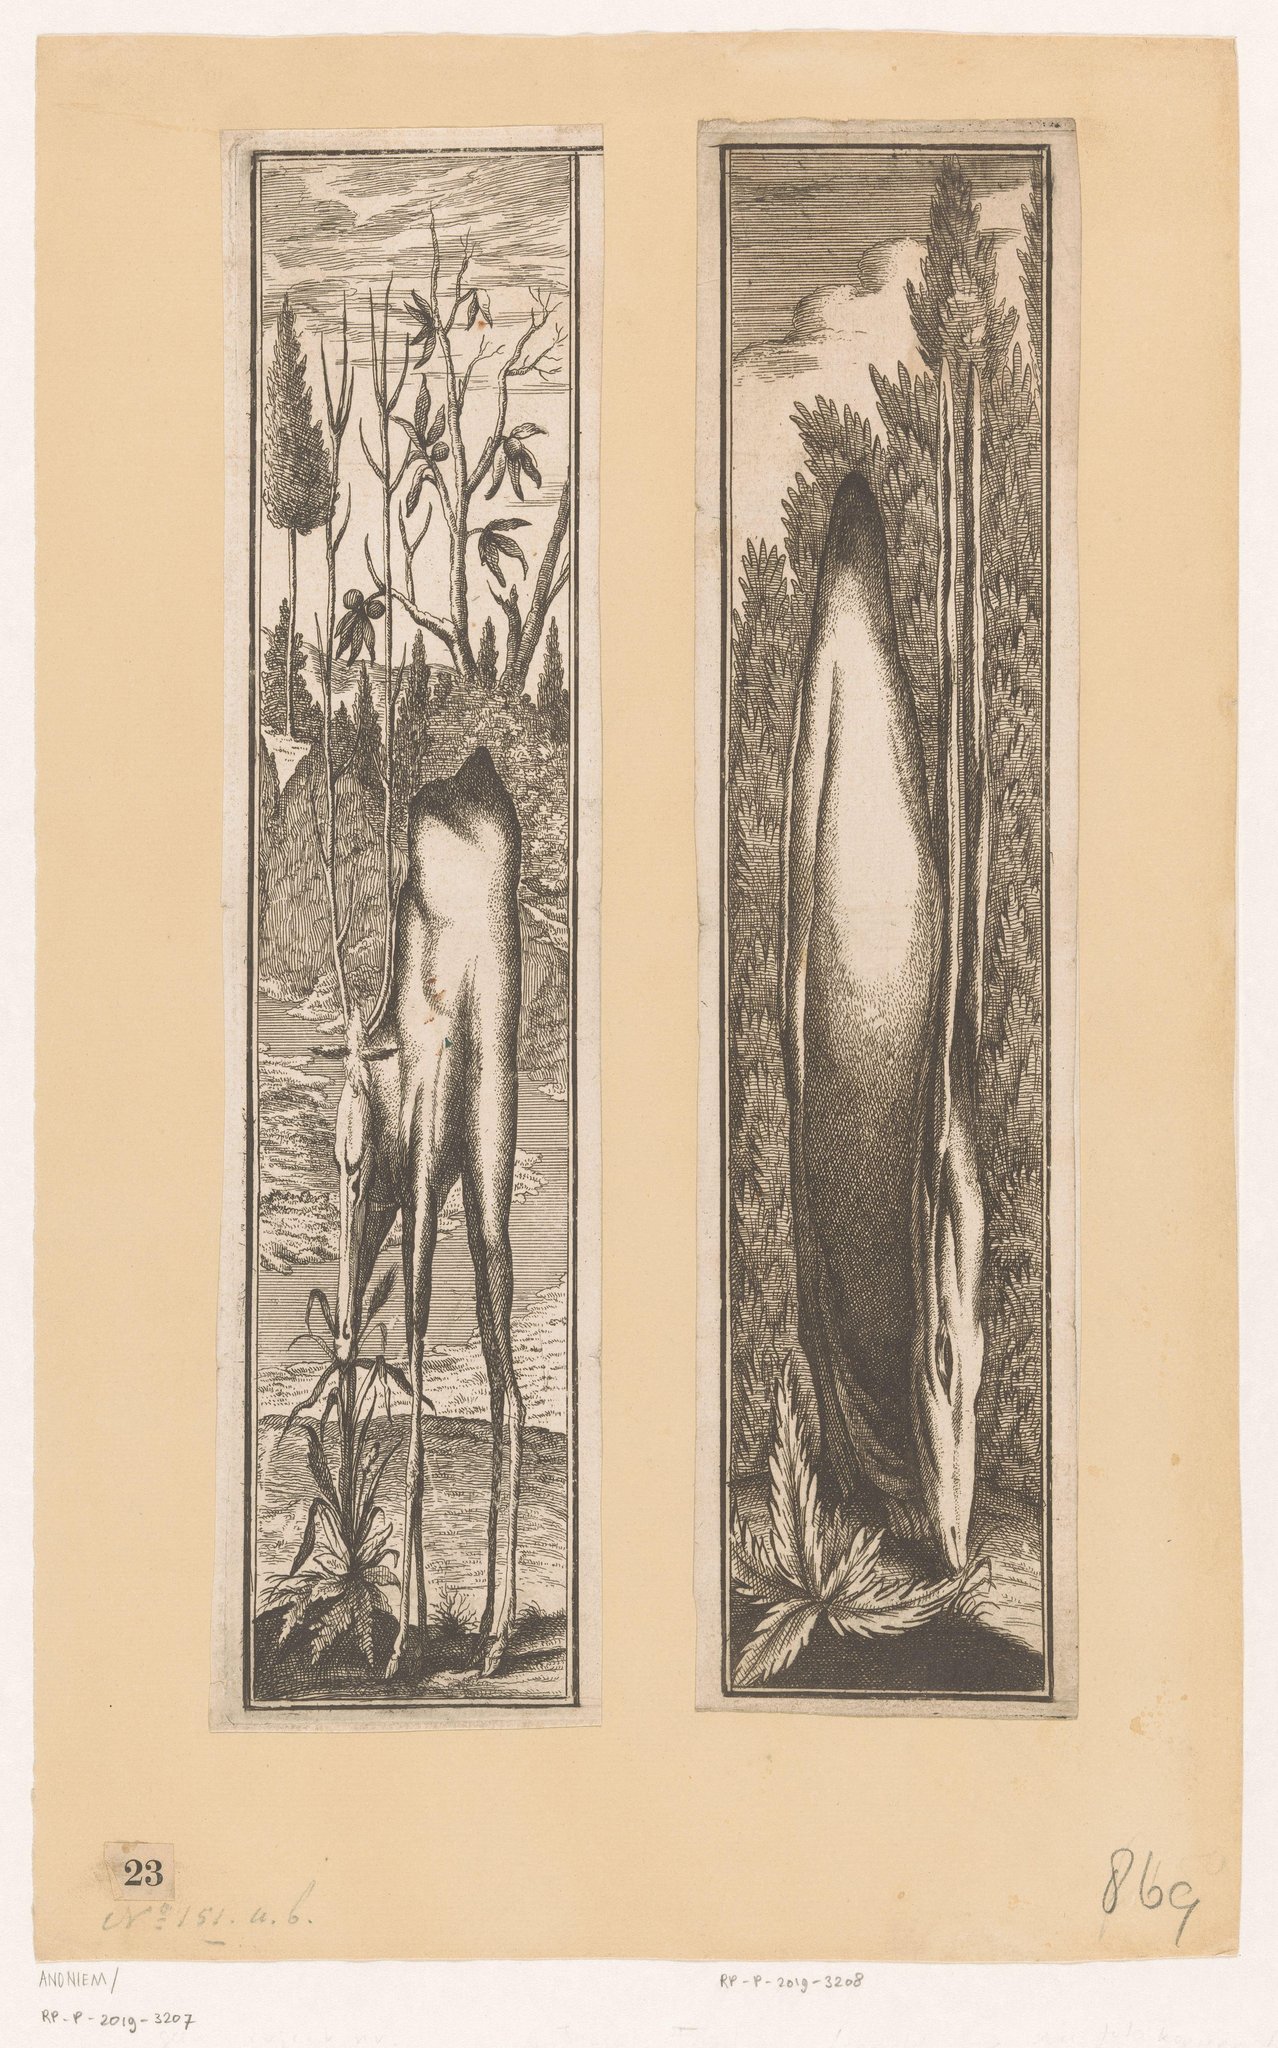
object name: print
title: Anamorfose van een grazend hert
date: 1678-1727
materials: paper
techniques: etching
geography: augsburg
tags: hoofed animals: deer, anamorphosis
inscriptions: number: ‘869’, collector's mark: Lugt 2028, collector's mark: Lugt 2228, inscription: ‘No. 151. u.b.’, number: ‘23’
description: Dit betreft een spiegelbeeldige kopie naar plaat zes van een zesdelige serie met anamorfosen van verschillende dieren, uitgegeven door Joseph Friedrich Leopold in Augsburg.